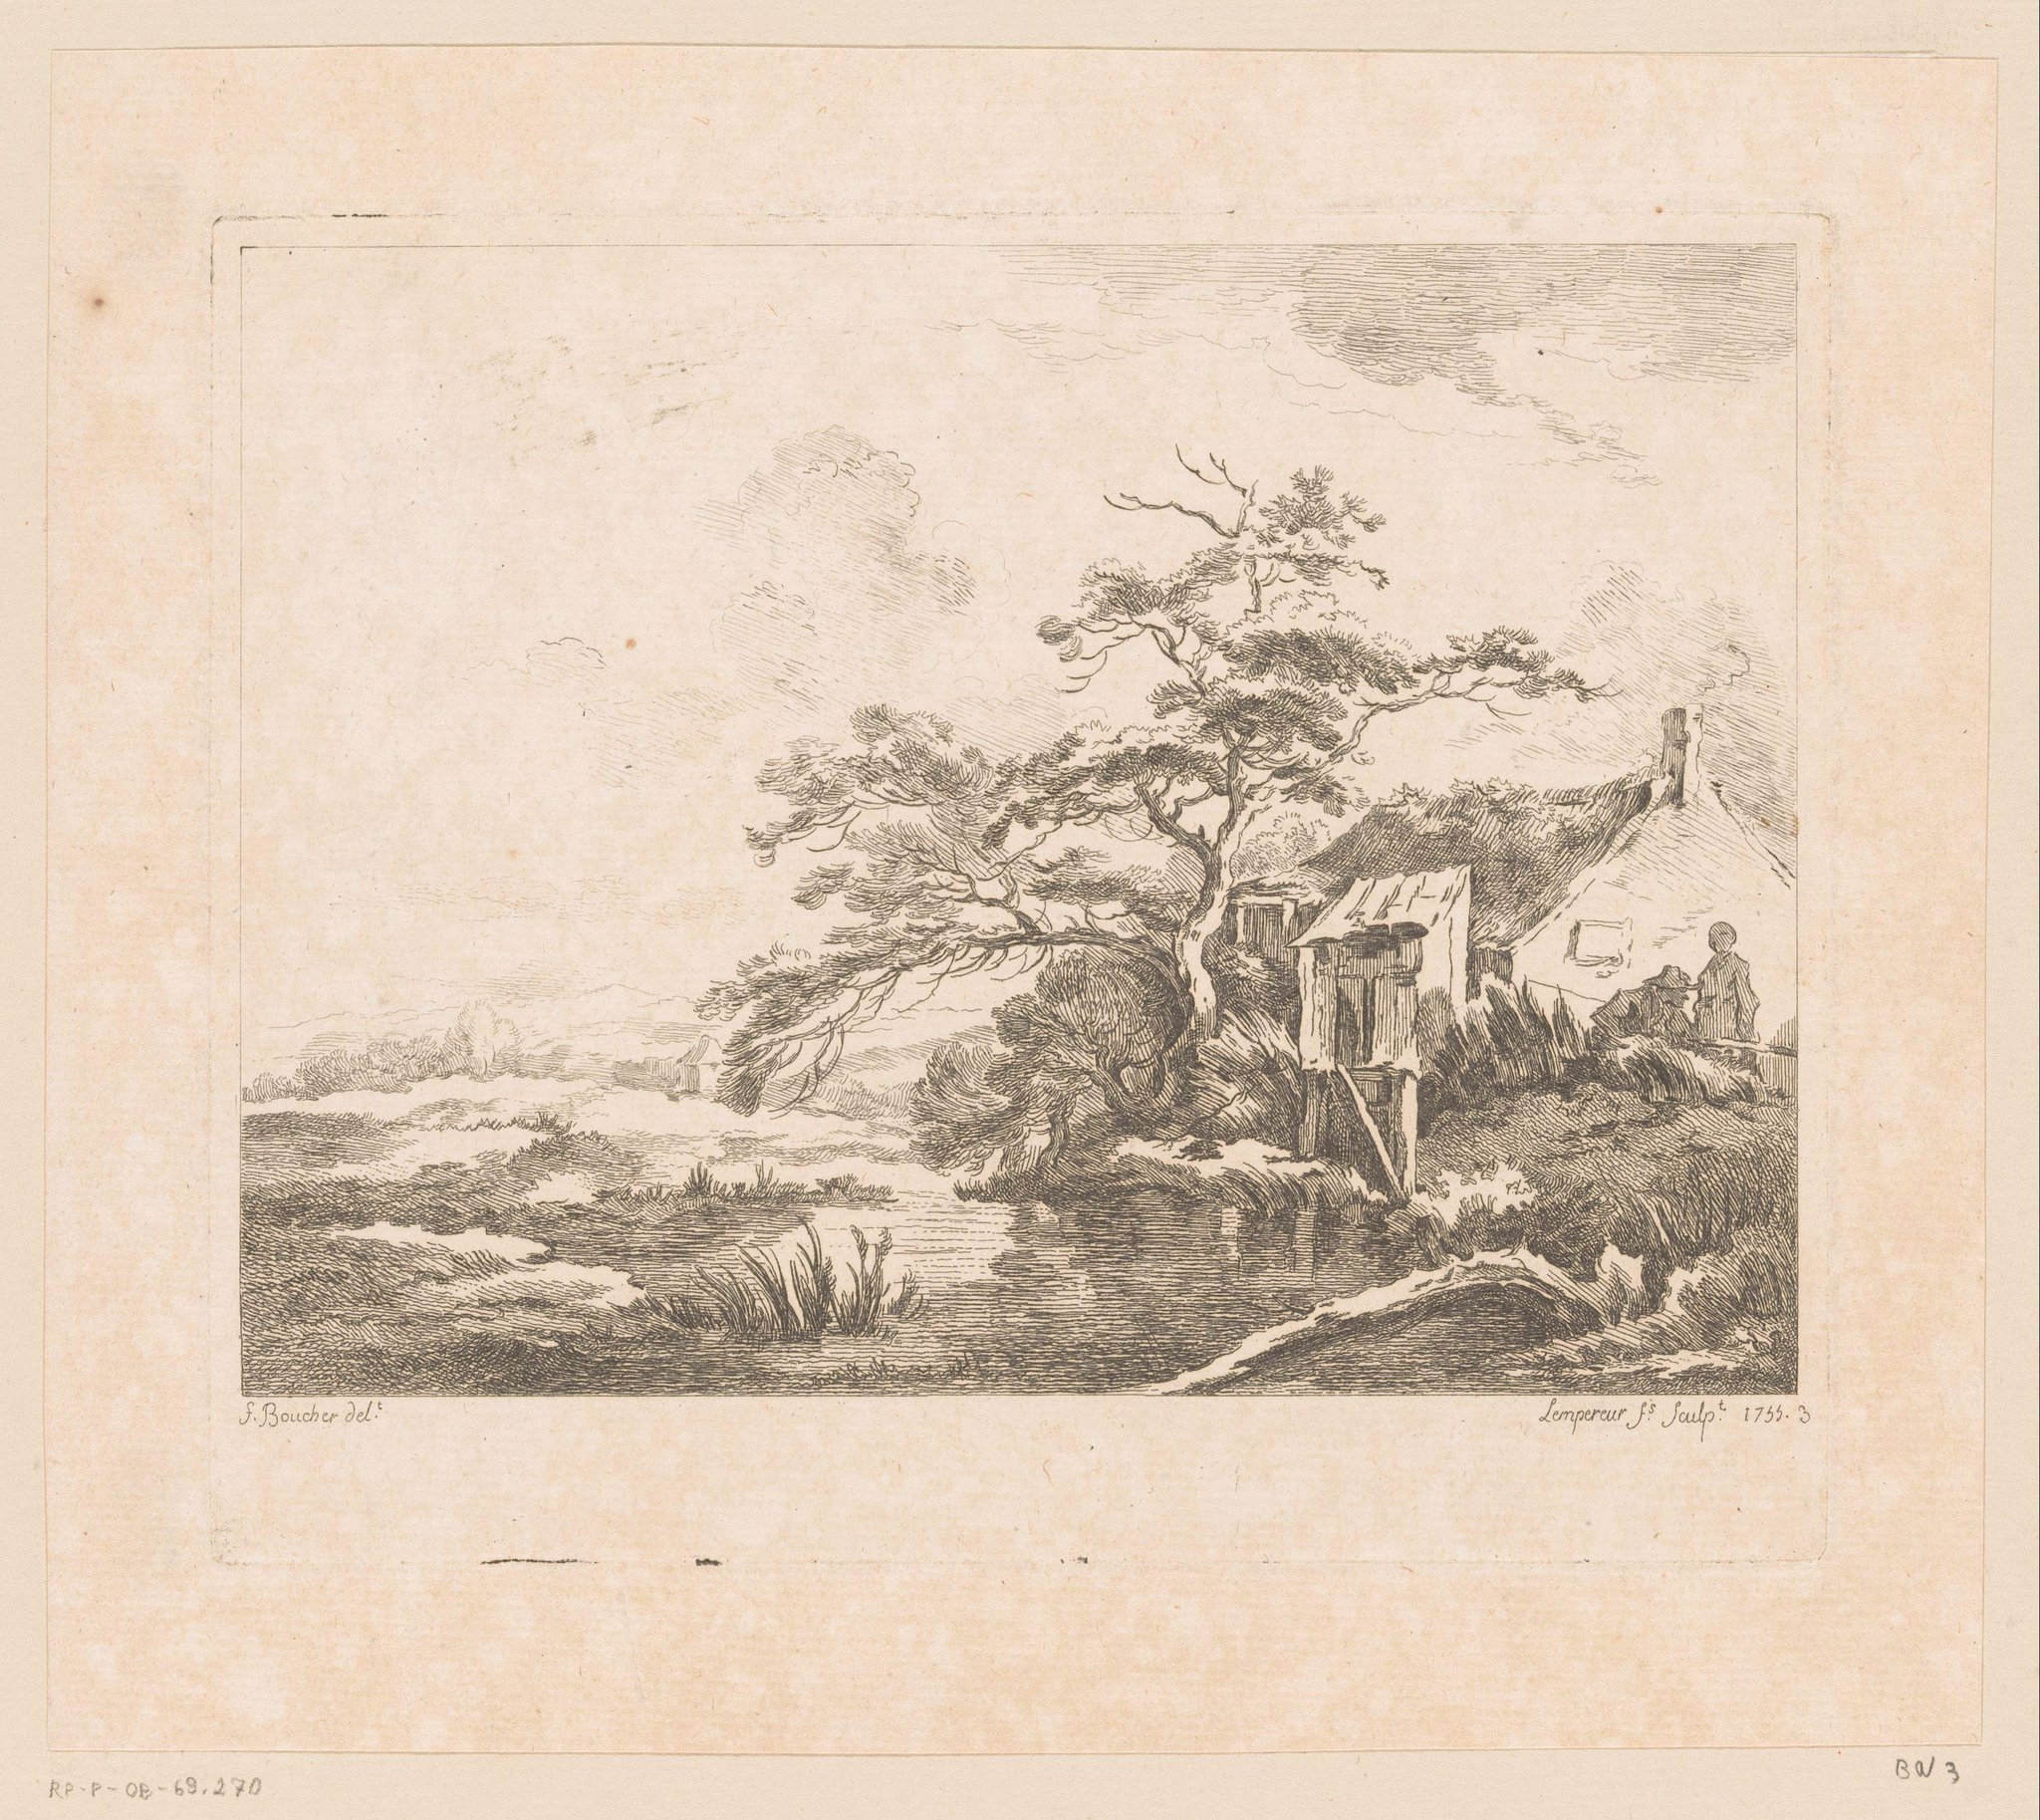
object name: print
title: Landschap met twee mannen bij een rivier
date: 1755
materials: paper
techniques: etching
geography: france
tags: river, adult man, rural housing, e.g. country-house, villa, cottage - aa - civic architecture: inside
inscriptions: collector's mark: Lugt 240